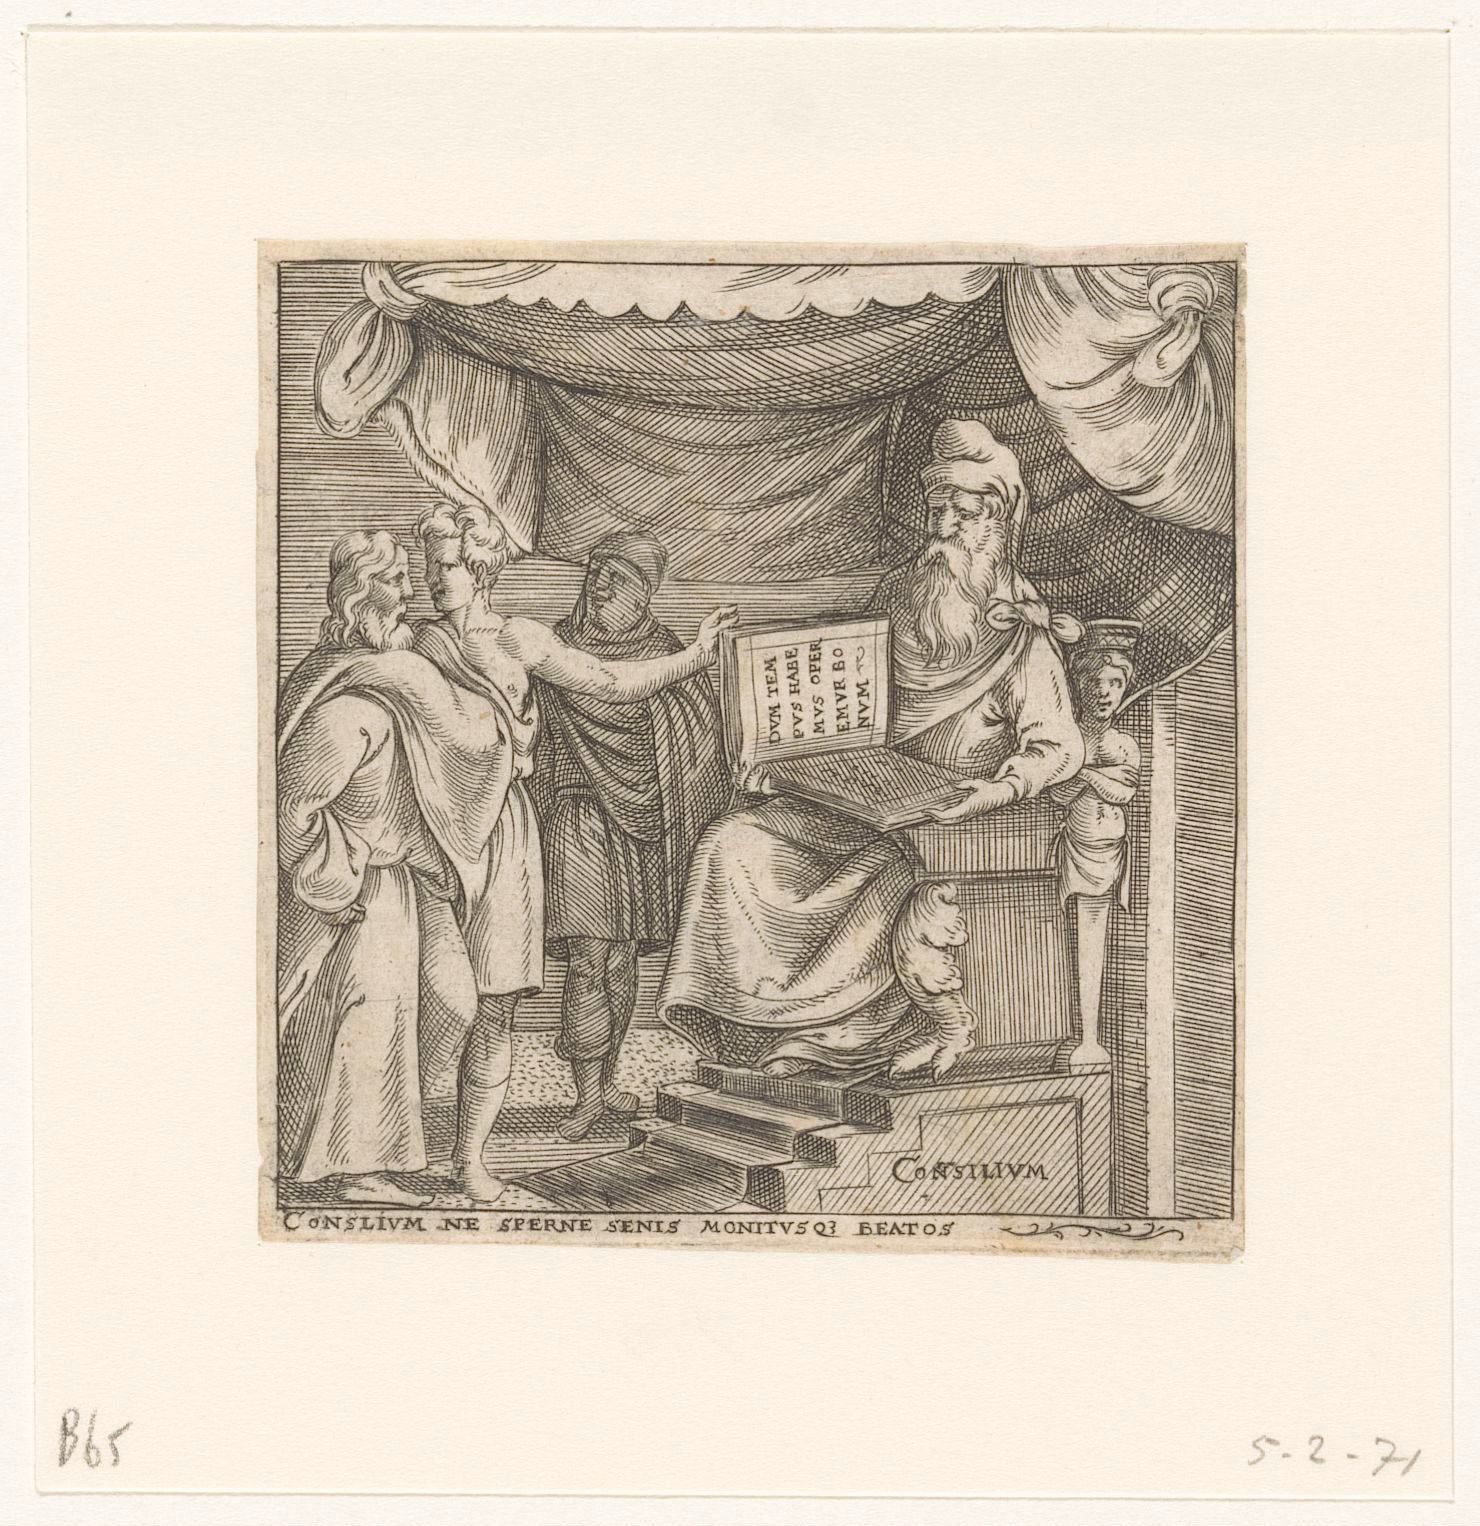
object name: print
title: Consilium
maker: francesco salviati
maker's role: draughtsman, painter, print maker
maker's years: 1510-1563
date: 1533-1567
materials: paper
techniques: engraving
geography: italy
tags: 'consilium', counsel ~ one of the seven gifts of the holy ghost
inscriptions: collector's mark: Lugt 2166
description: Een rechter met een opengeslagen boek [... tempus habemus, operemur bonum...]. Voor hem staan drie mannen. Regel Latijnse tekst in ondermarge.